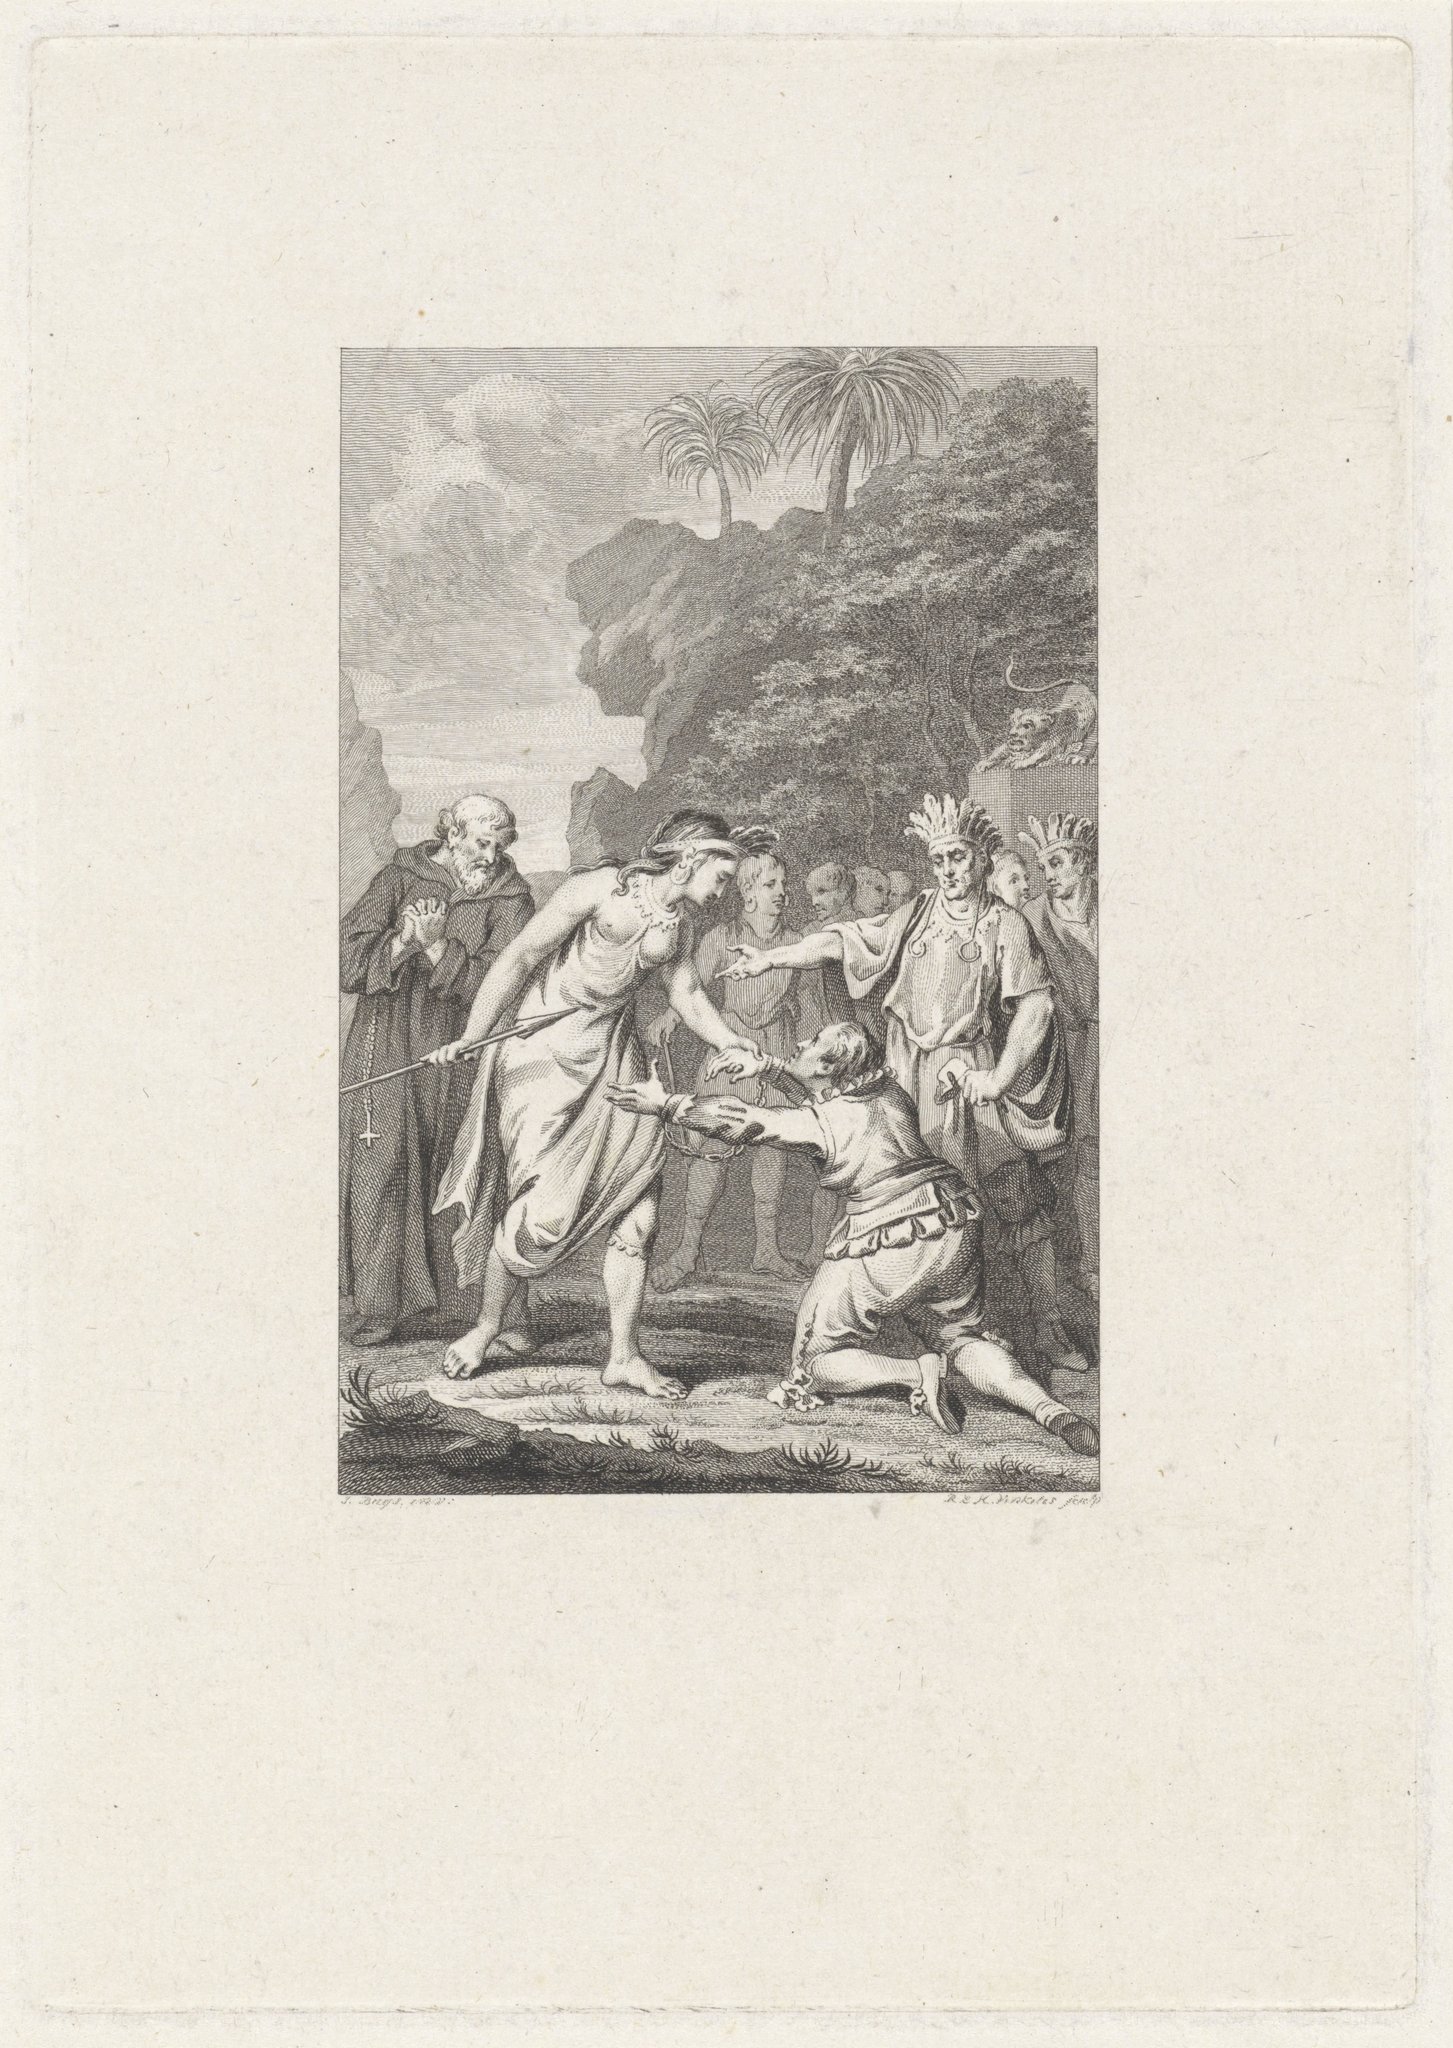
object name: print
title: Geboeide man knielt voor een vrouw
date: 1751-1816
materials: paper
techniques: engraving, etching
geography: amsterdam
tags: indigenous peoples of north america, kneeling figure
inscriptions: collector's mark: Lugt 2228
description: Omringd door oorspronkelijke Amerikanen en een monnik knielt een geboeide man, mogelijk John Smith, voor een vrouw, mogelijk Pocahontas.